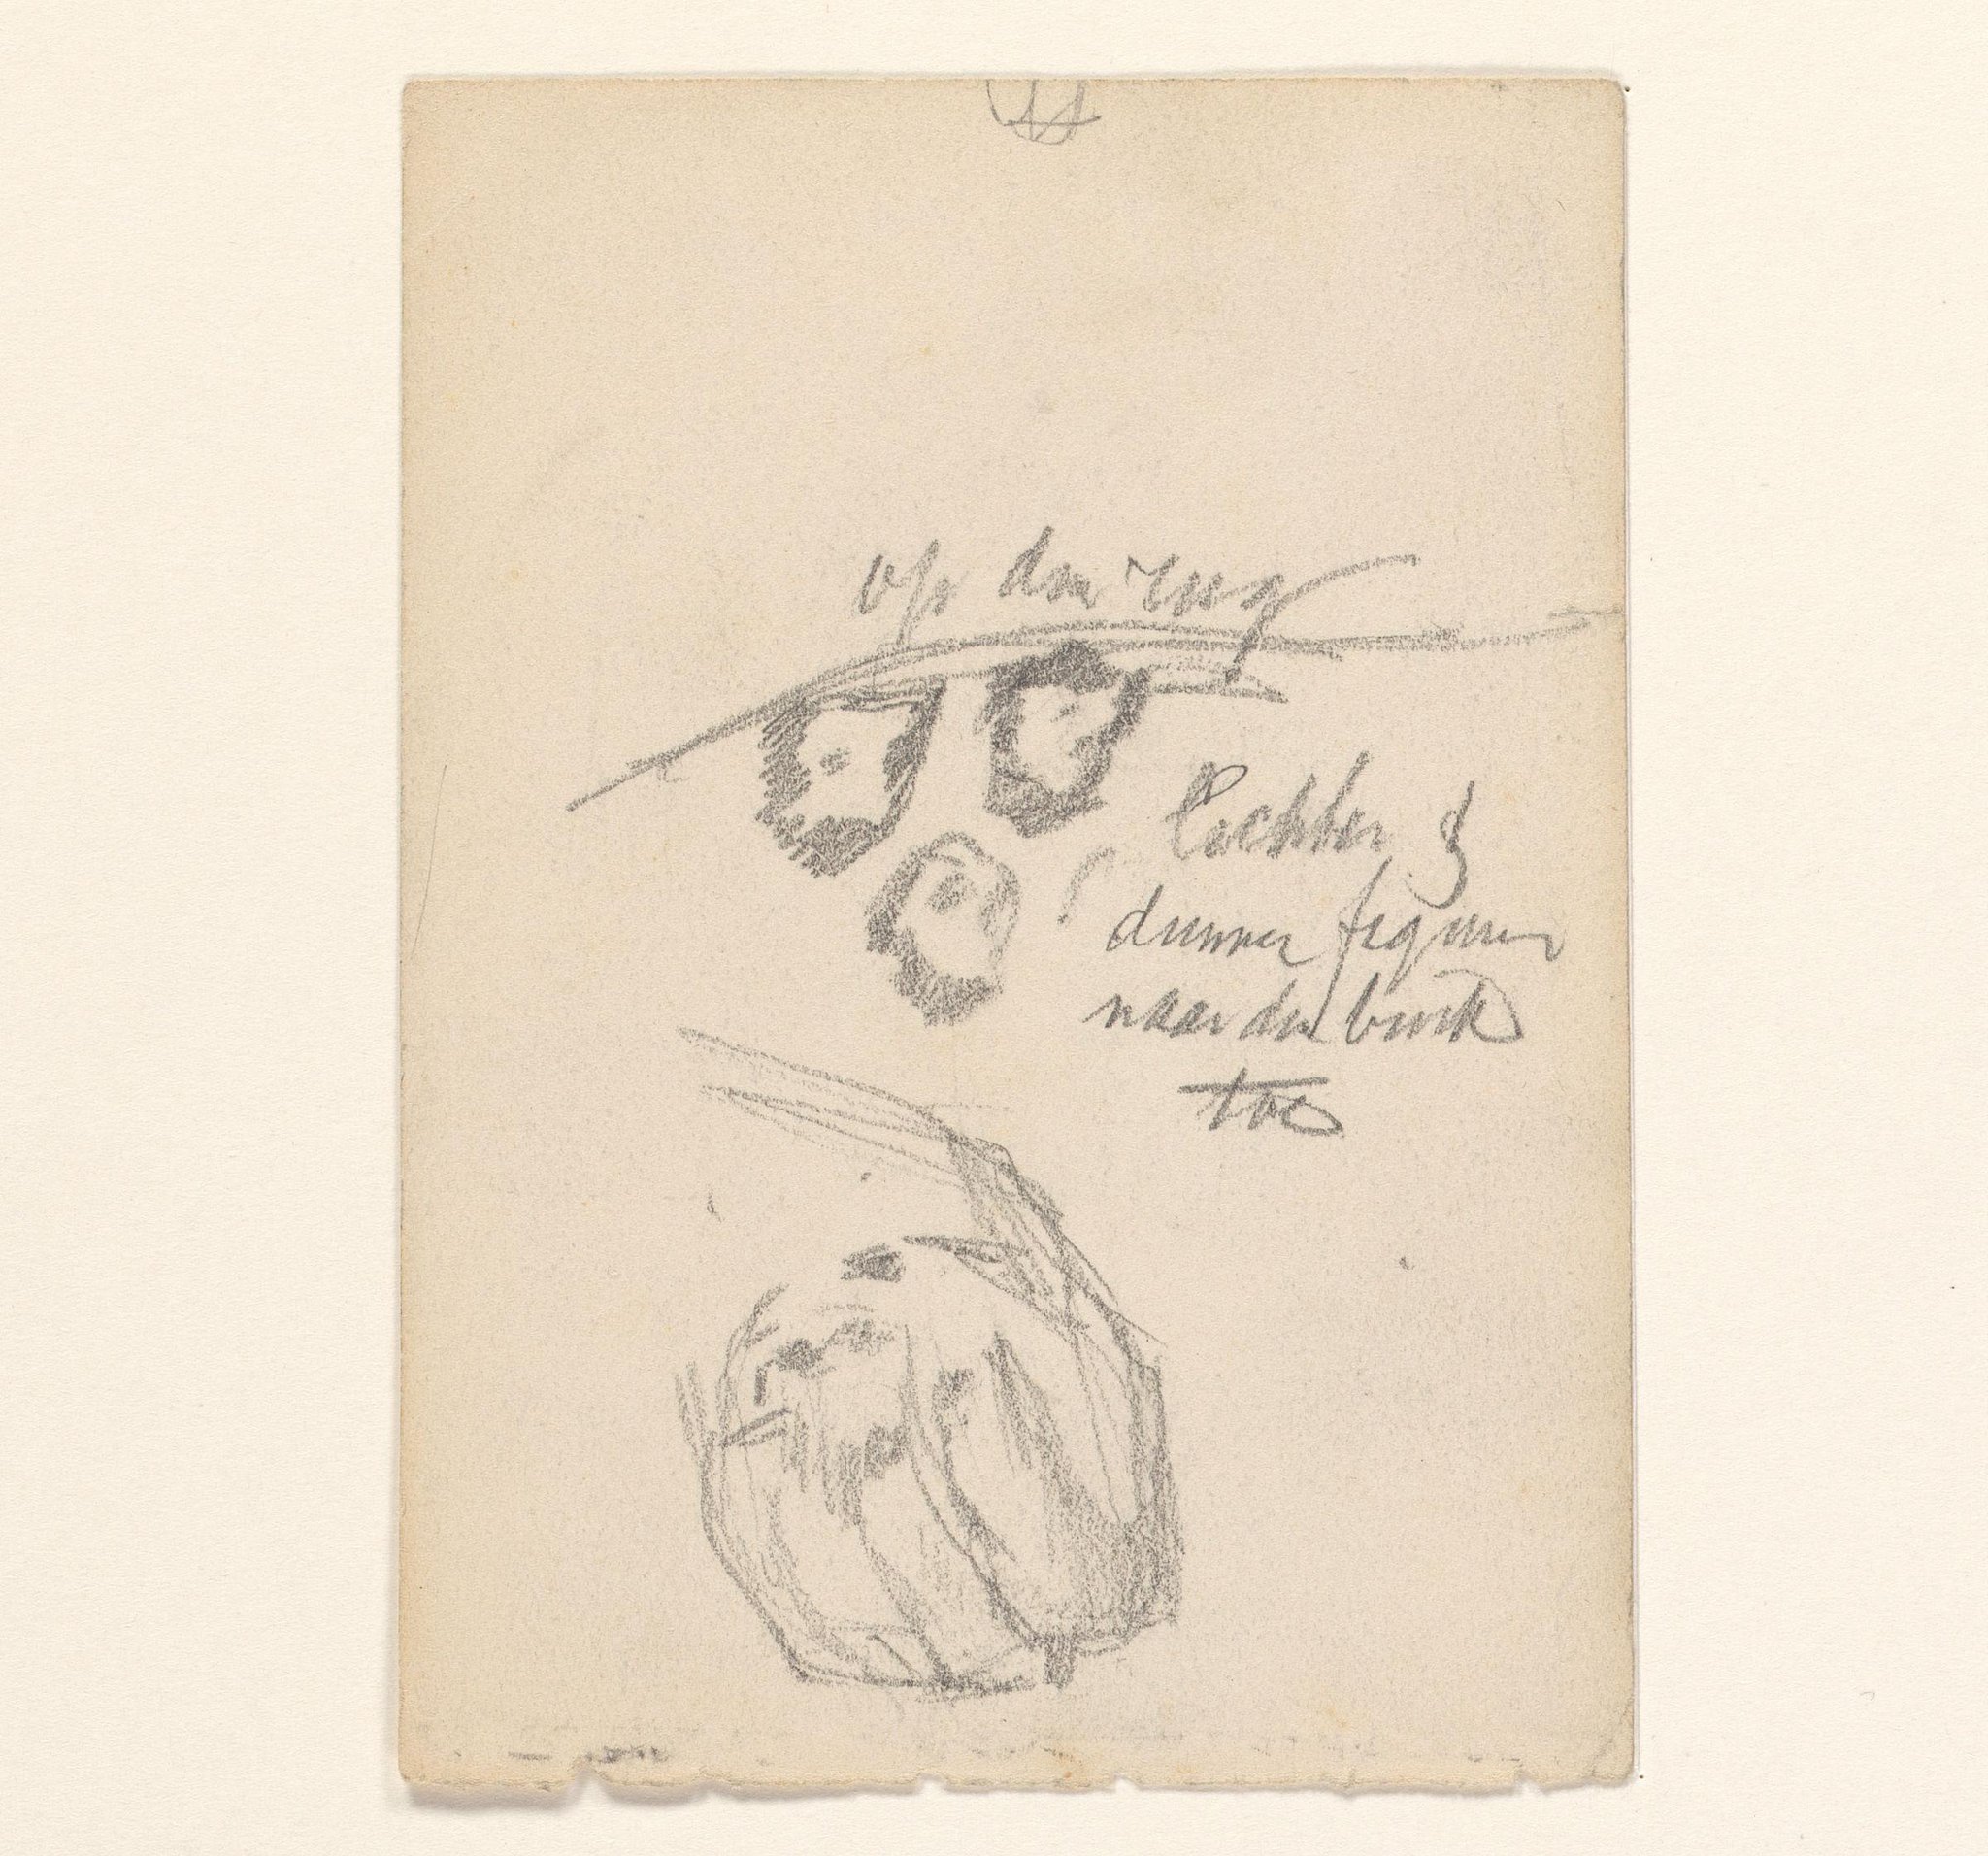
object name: drawing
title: Poot en rug van een luipaard (?)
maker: august allebé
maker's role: draughtsman, print maker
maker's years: 1838-1927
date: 1848-1927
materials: paper, pencil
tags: beasts of prey, predatory animals: leopard (+ claws, paws of an animal)